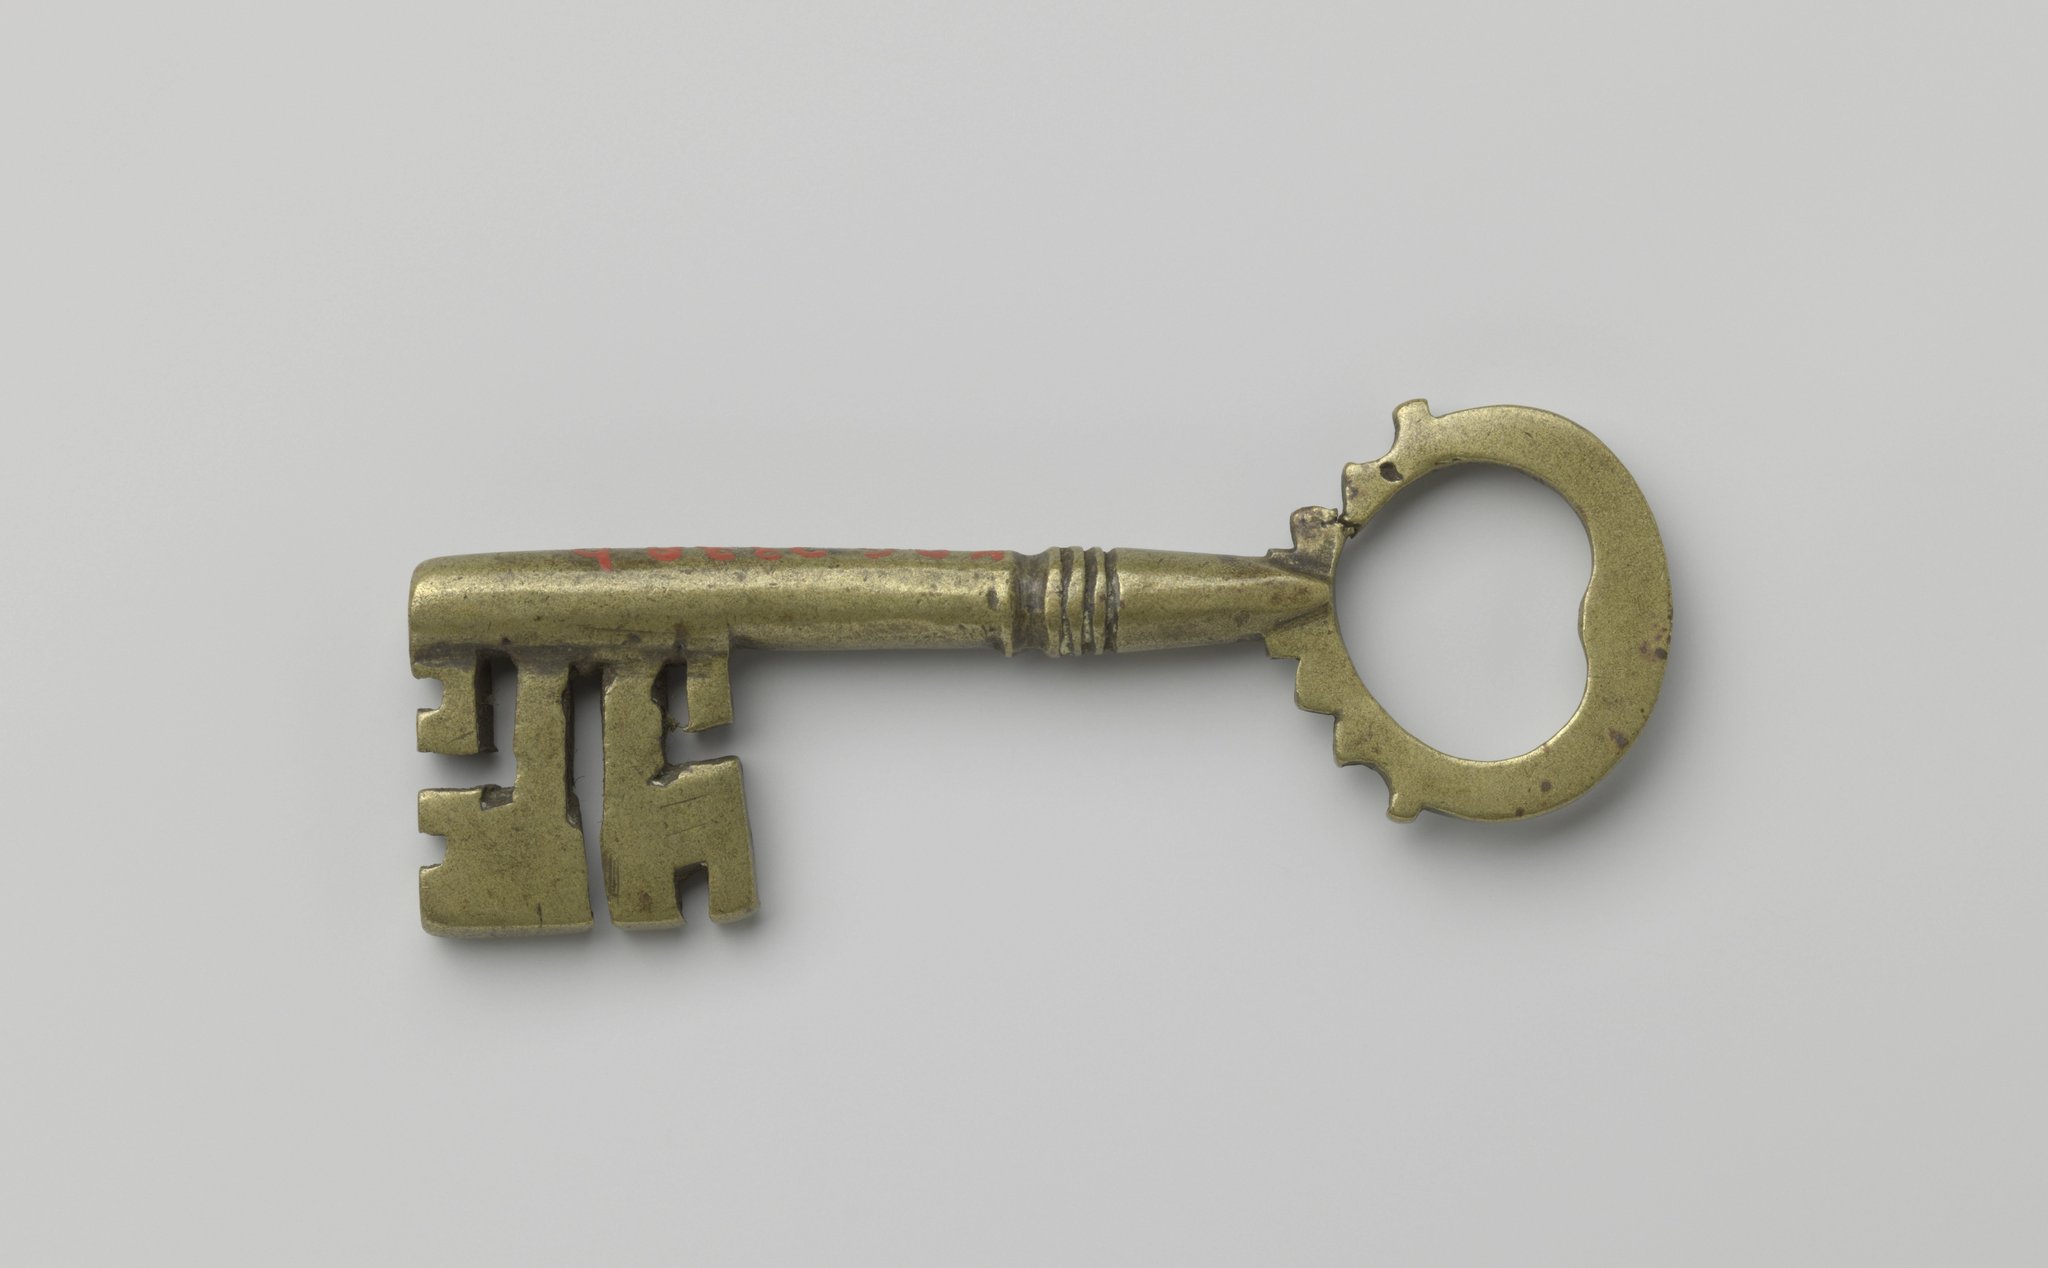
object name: key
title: Sleutel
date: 1400-1950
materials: copper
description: Sleutel waarvan het ovale oog onderaan gekanteld is. De schacht is in het midden geprofileerd.